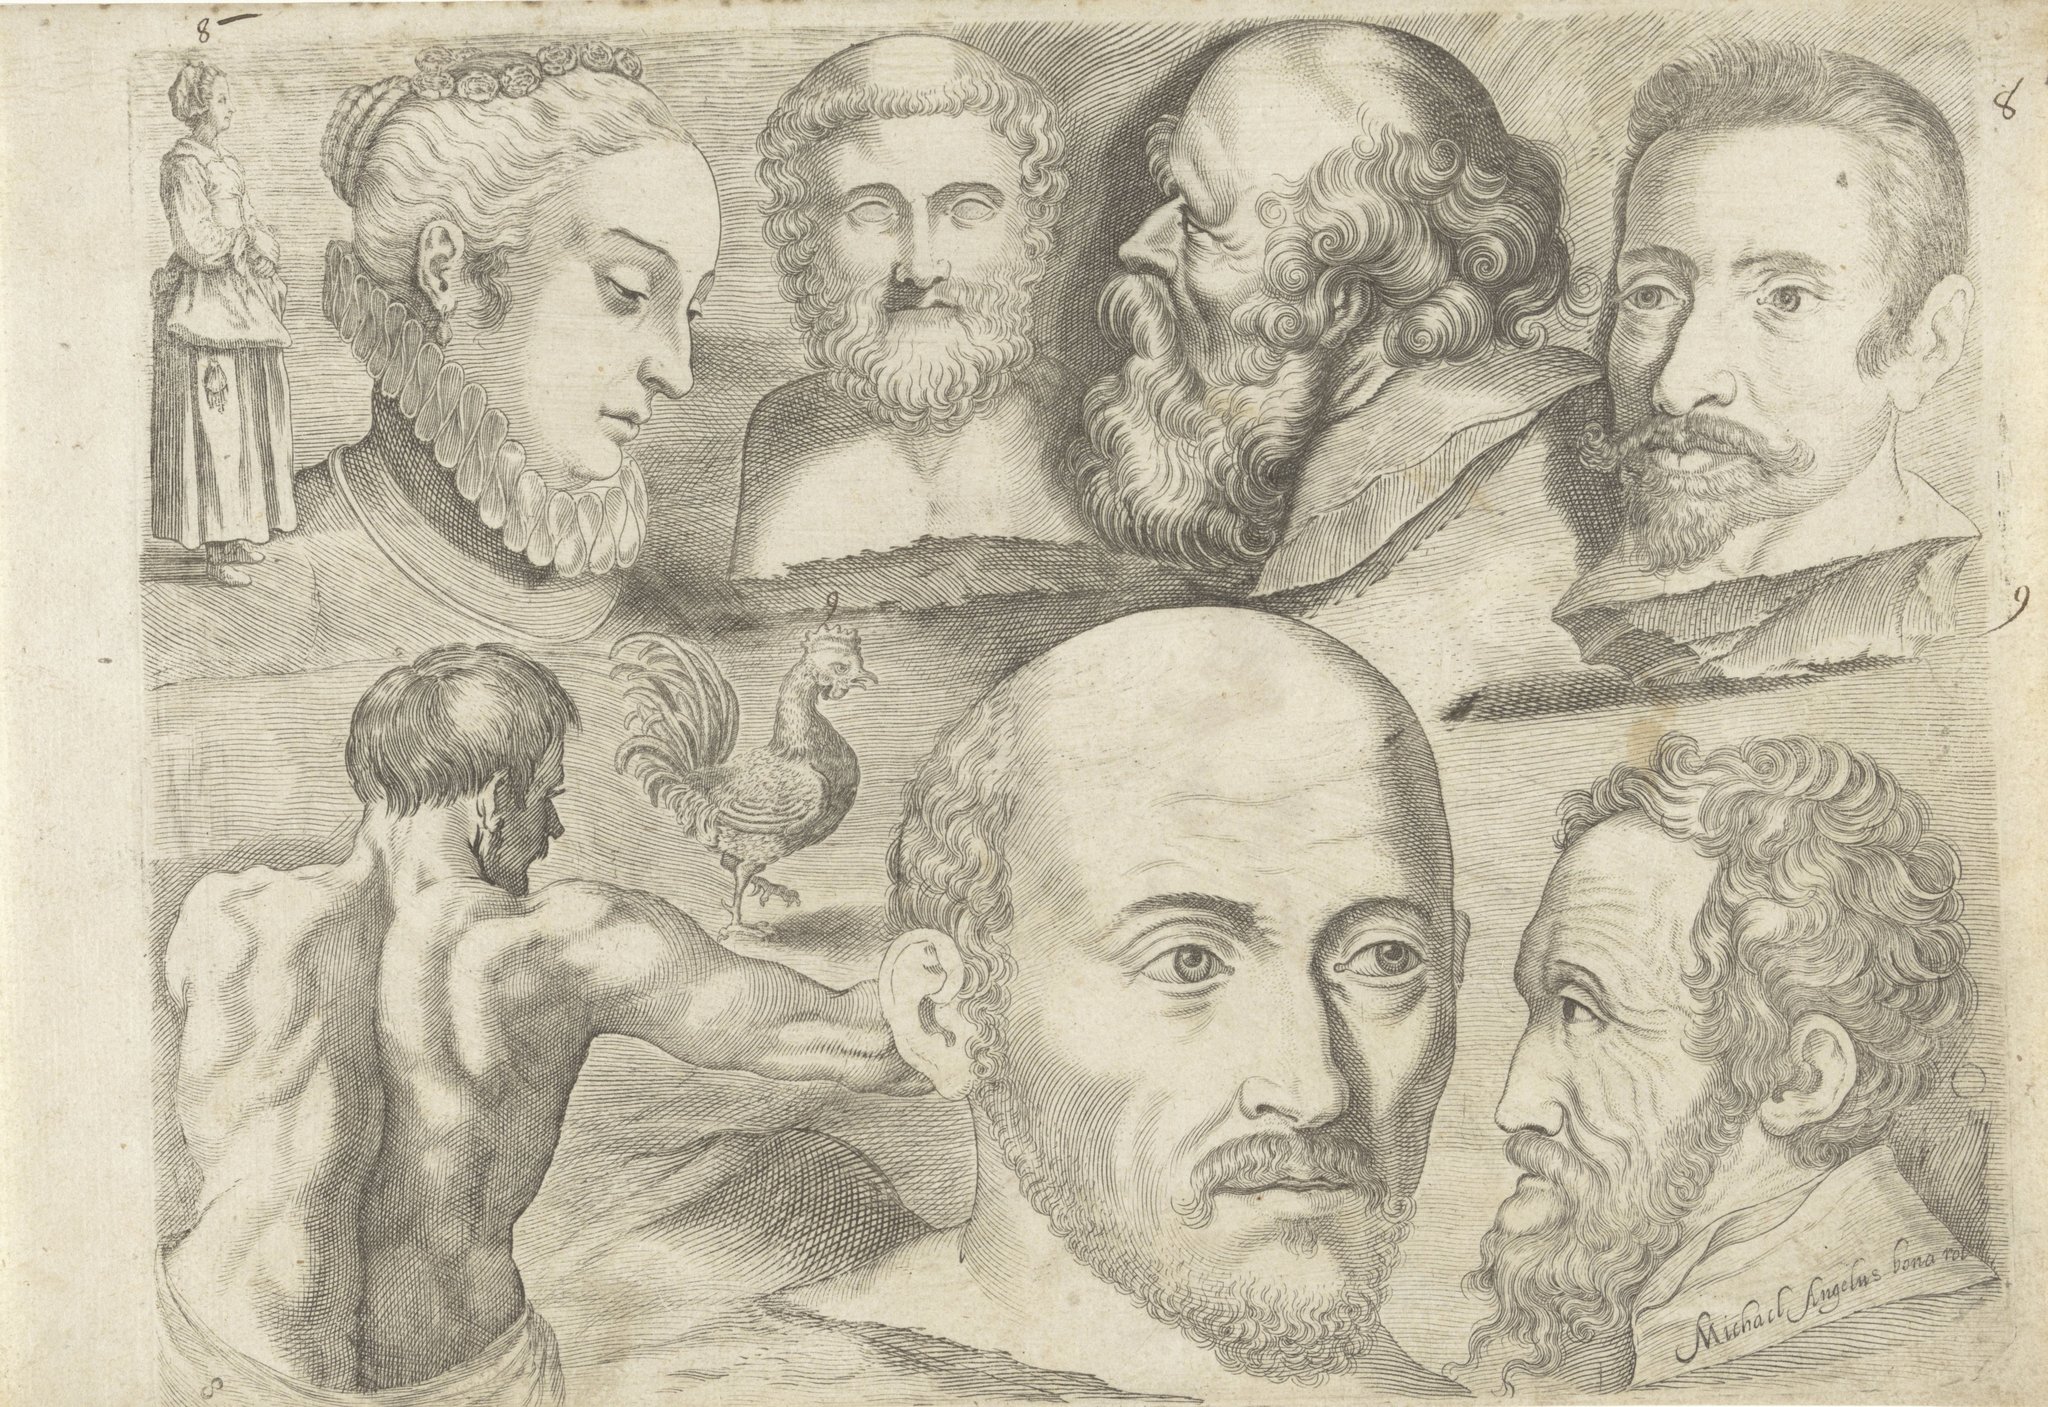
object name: print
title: Tekenvoorbeelden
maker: michael snijders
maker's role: print maker, publisher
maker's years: 1586-1672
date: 1610-1672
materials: paper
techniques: engraving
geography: antwerp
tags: rome, painter, draughtsman, sculptor, michelangelo, head (human), model-books ~ implements of painter, fowl (cock, hen, chicken, etc.), portrait, self-portrait of artist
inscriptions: collector's mark: Lugt 2228, collector's mark: Lugt 2760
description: Achtste prent uit een serie met tekenvoorbeelden. Studieblad met linksboven een staande vrouw. Daarnaast een vrouwenkop. Daaronder een haan en een naakte mannenfiguur op de rug gezien. Verder mannenkoppen, waaronder rechtsonder het portret van Michelangelo Buonarotti.